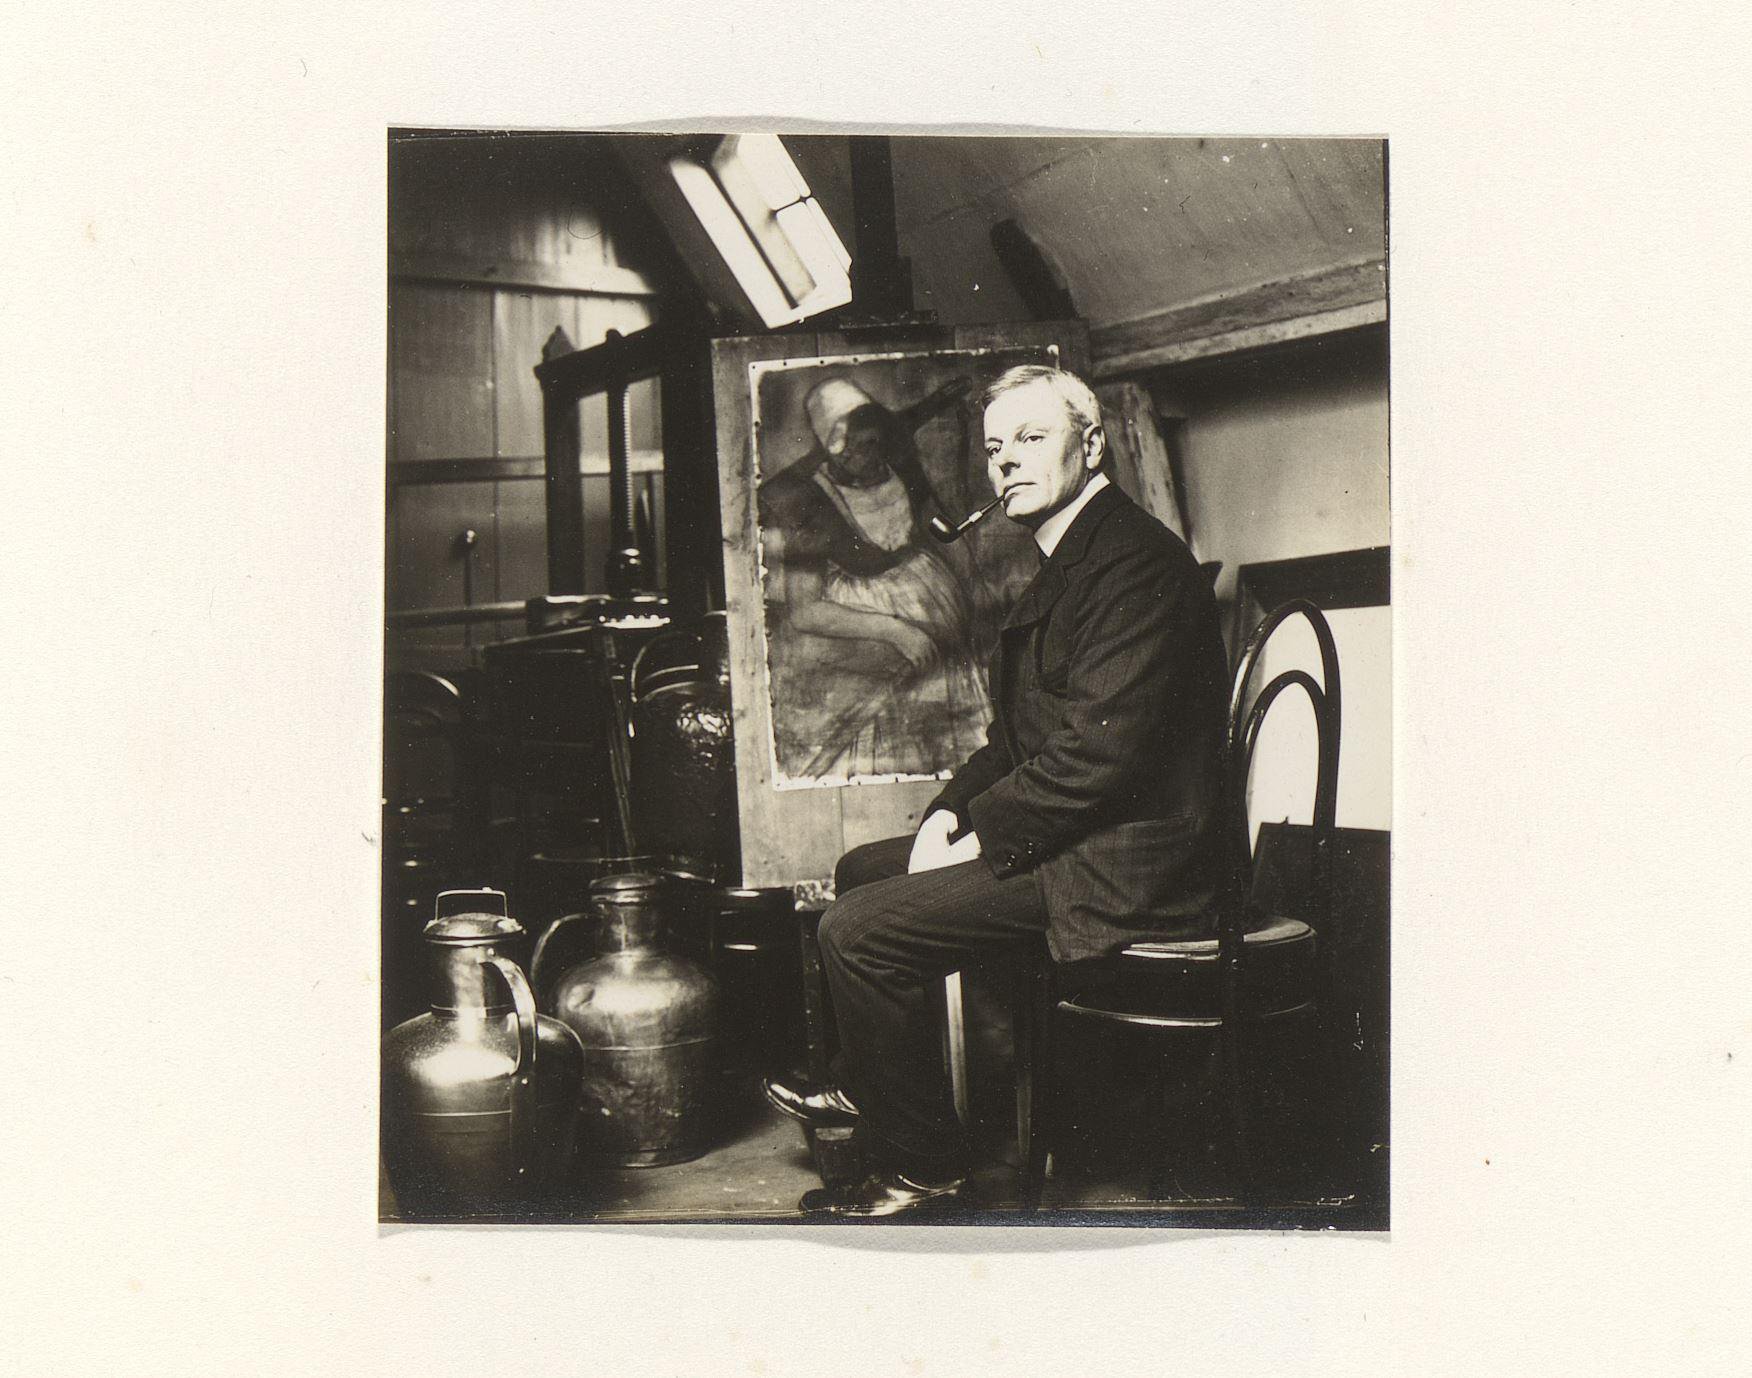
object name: album leaf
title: Man in een schildersatelier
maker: george hidderley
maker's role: fotograaf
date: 1900-1910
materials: paper, photographic support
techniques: gelatin silver print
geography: volendam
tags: adult man, historical persons, workshop, studio ~ painter